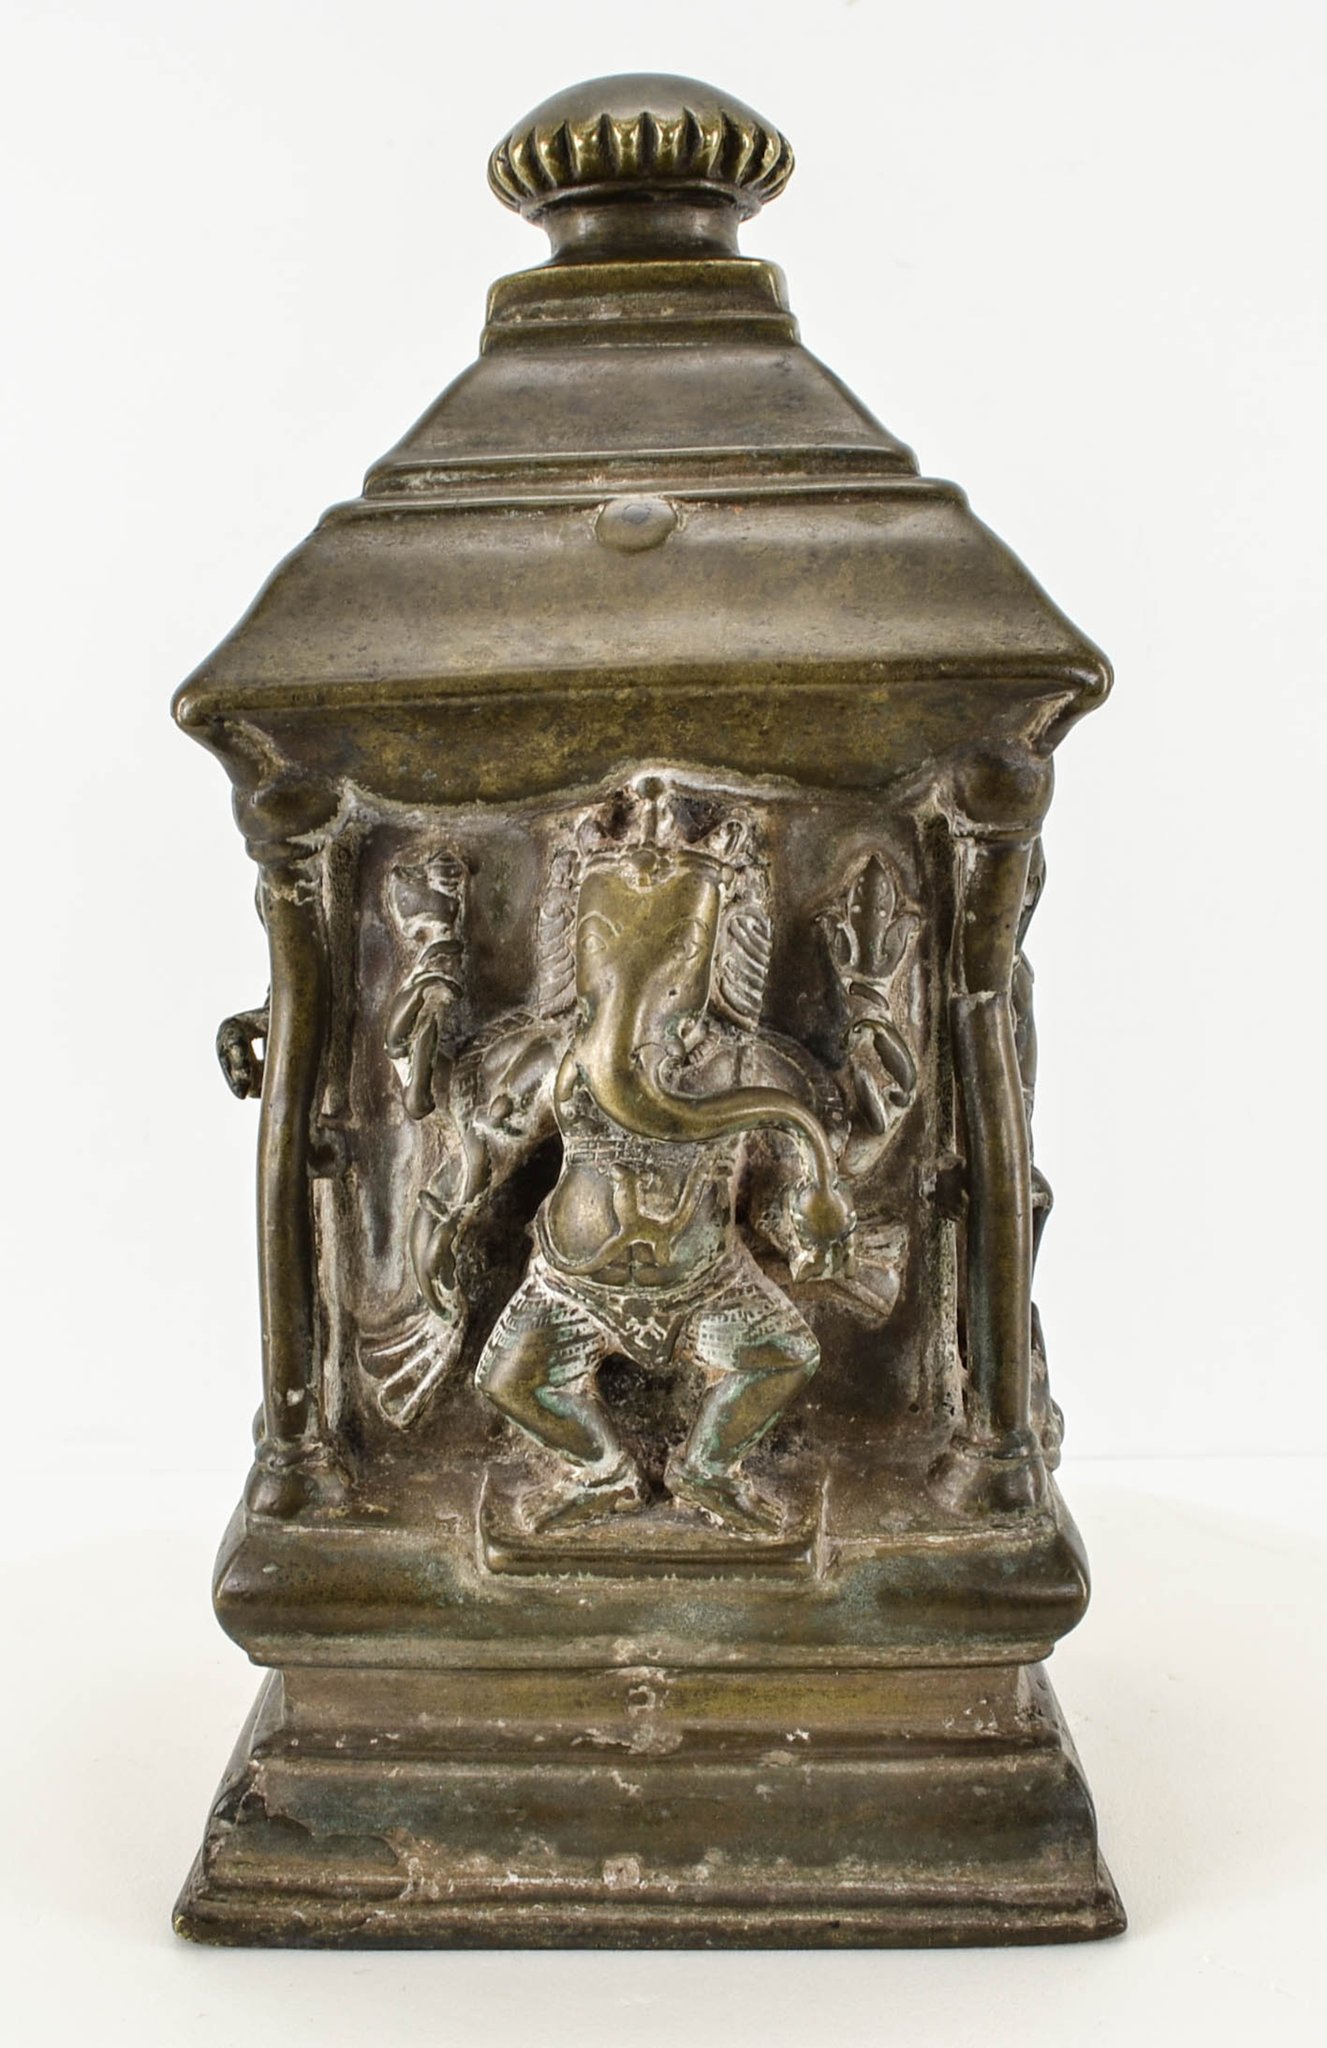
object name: shrine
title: Miniature Brahmanical Shrine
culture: india, himachal pradesh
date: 901-1000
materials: copper alloy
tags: ganesha,reliquaries